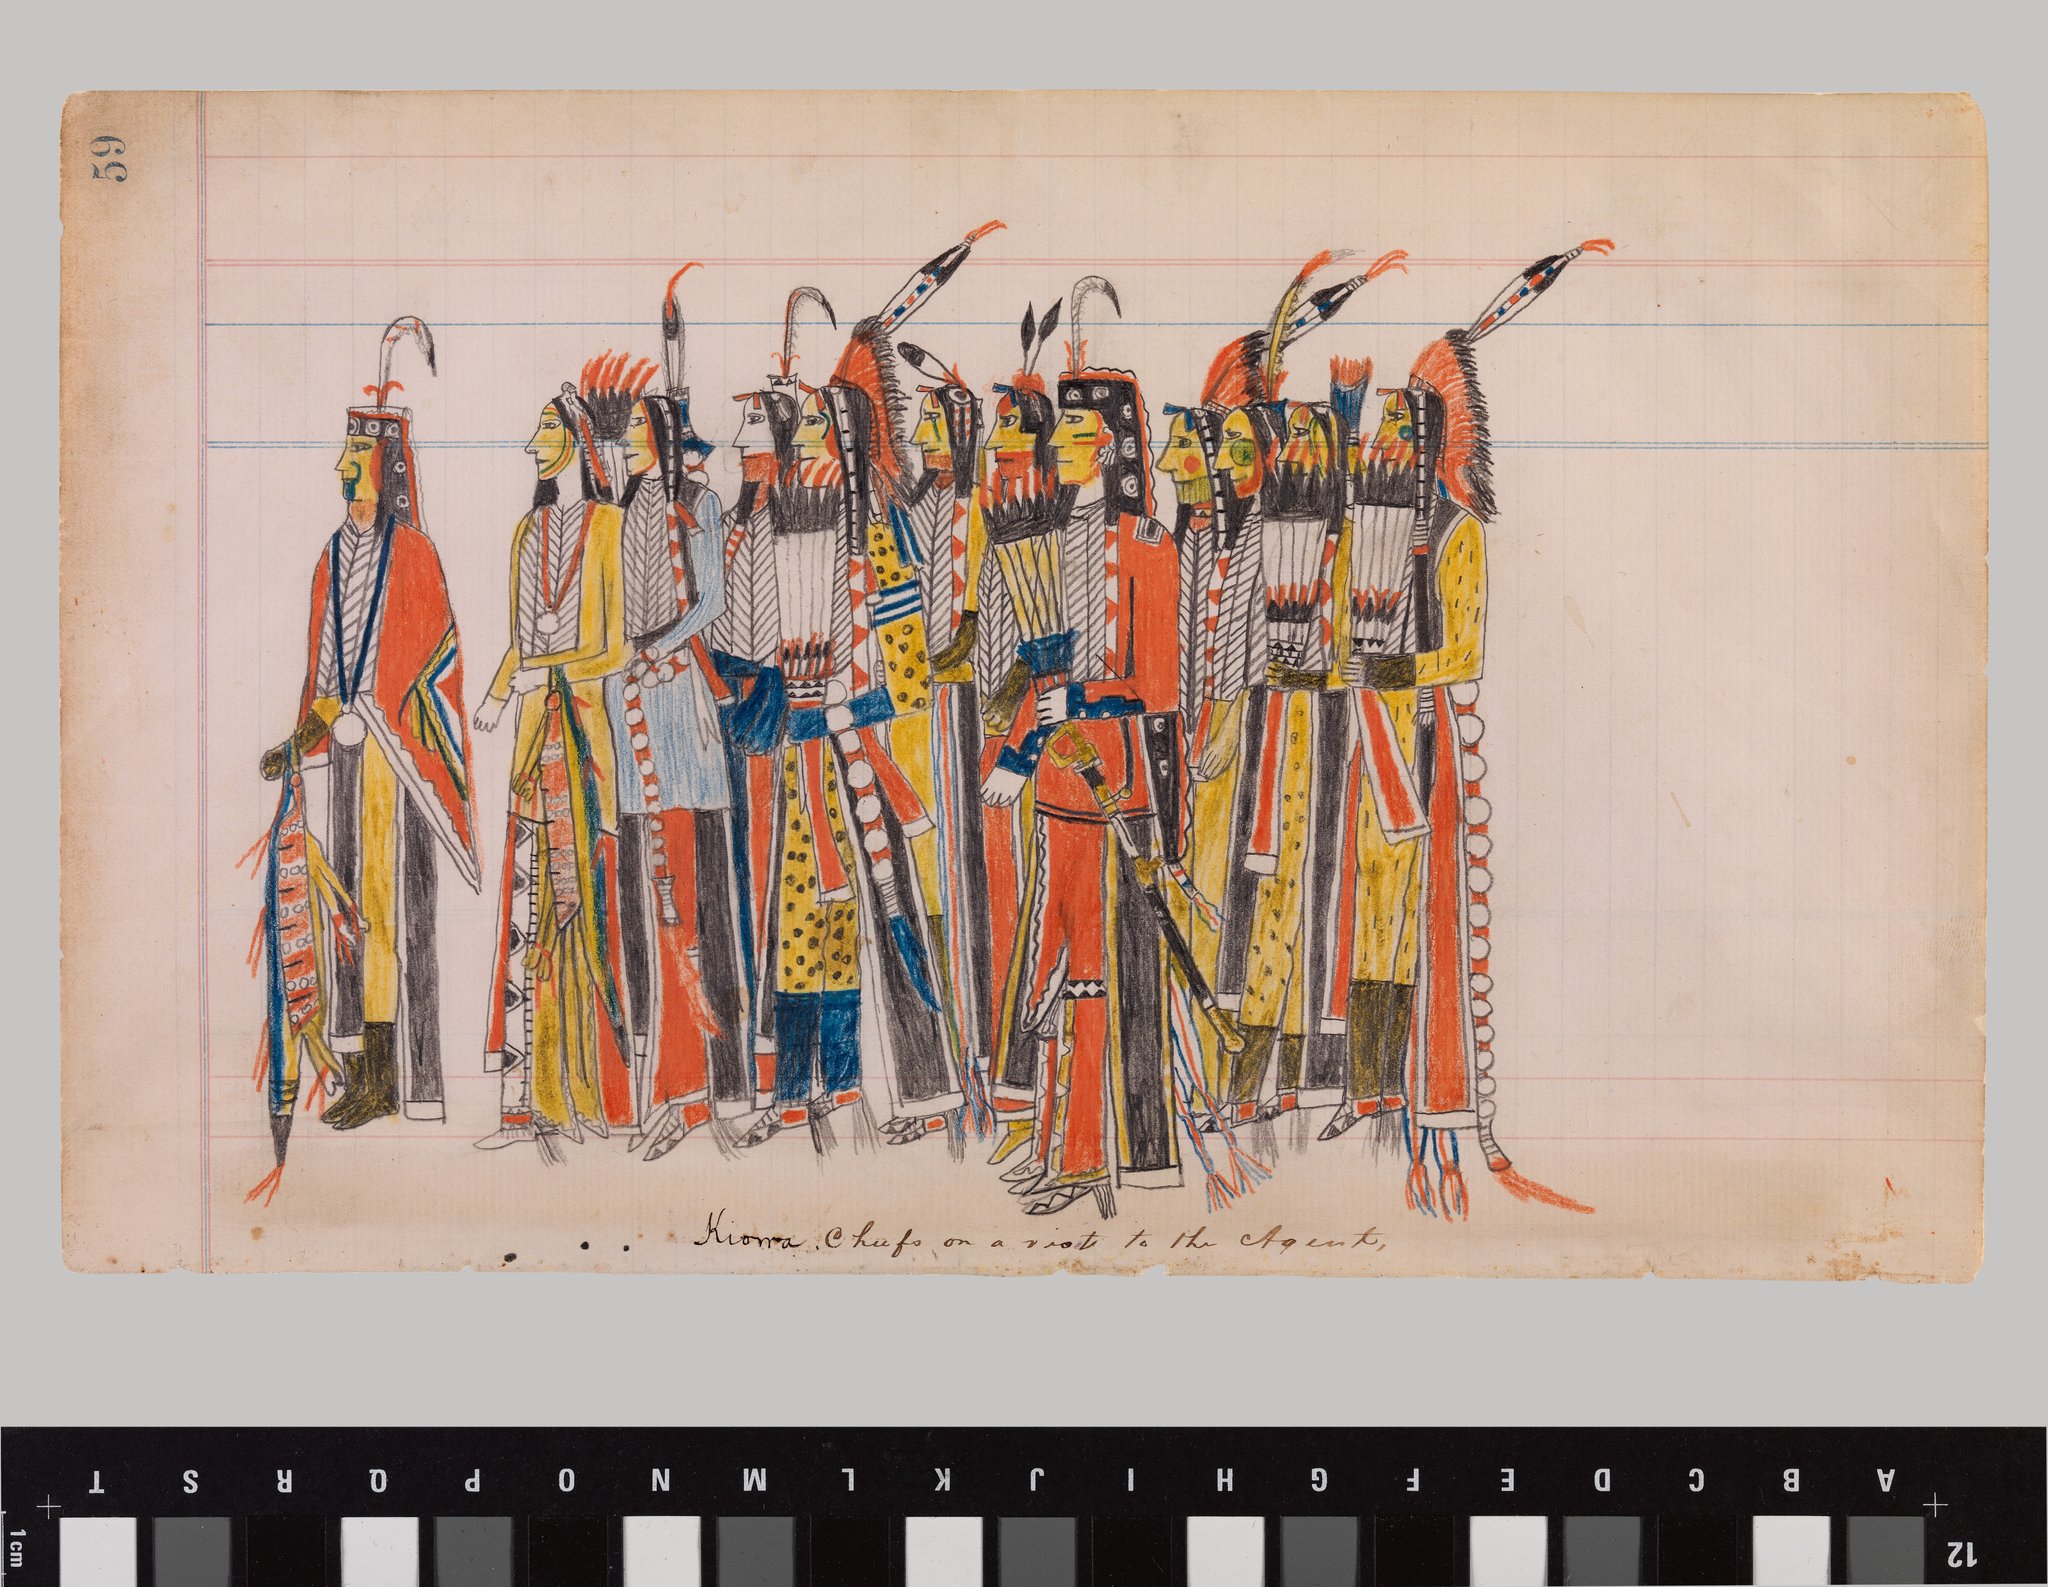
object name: ledger drawing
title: Kiowa Chiefs on a Visit to the Agent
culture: kiowa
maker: julian scott ledger artist b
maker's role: artist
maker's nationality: kiowa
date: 1880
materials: ink, paper, pencil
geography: united states